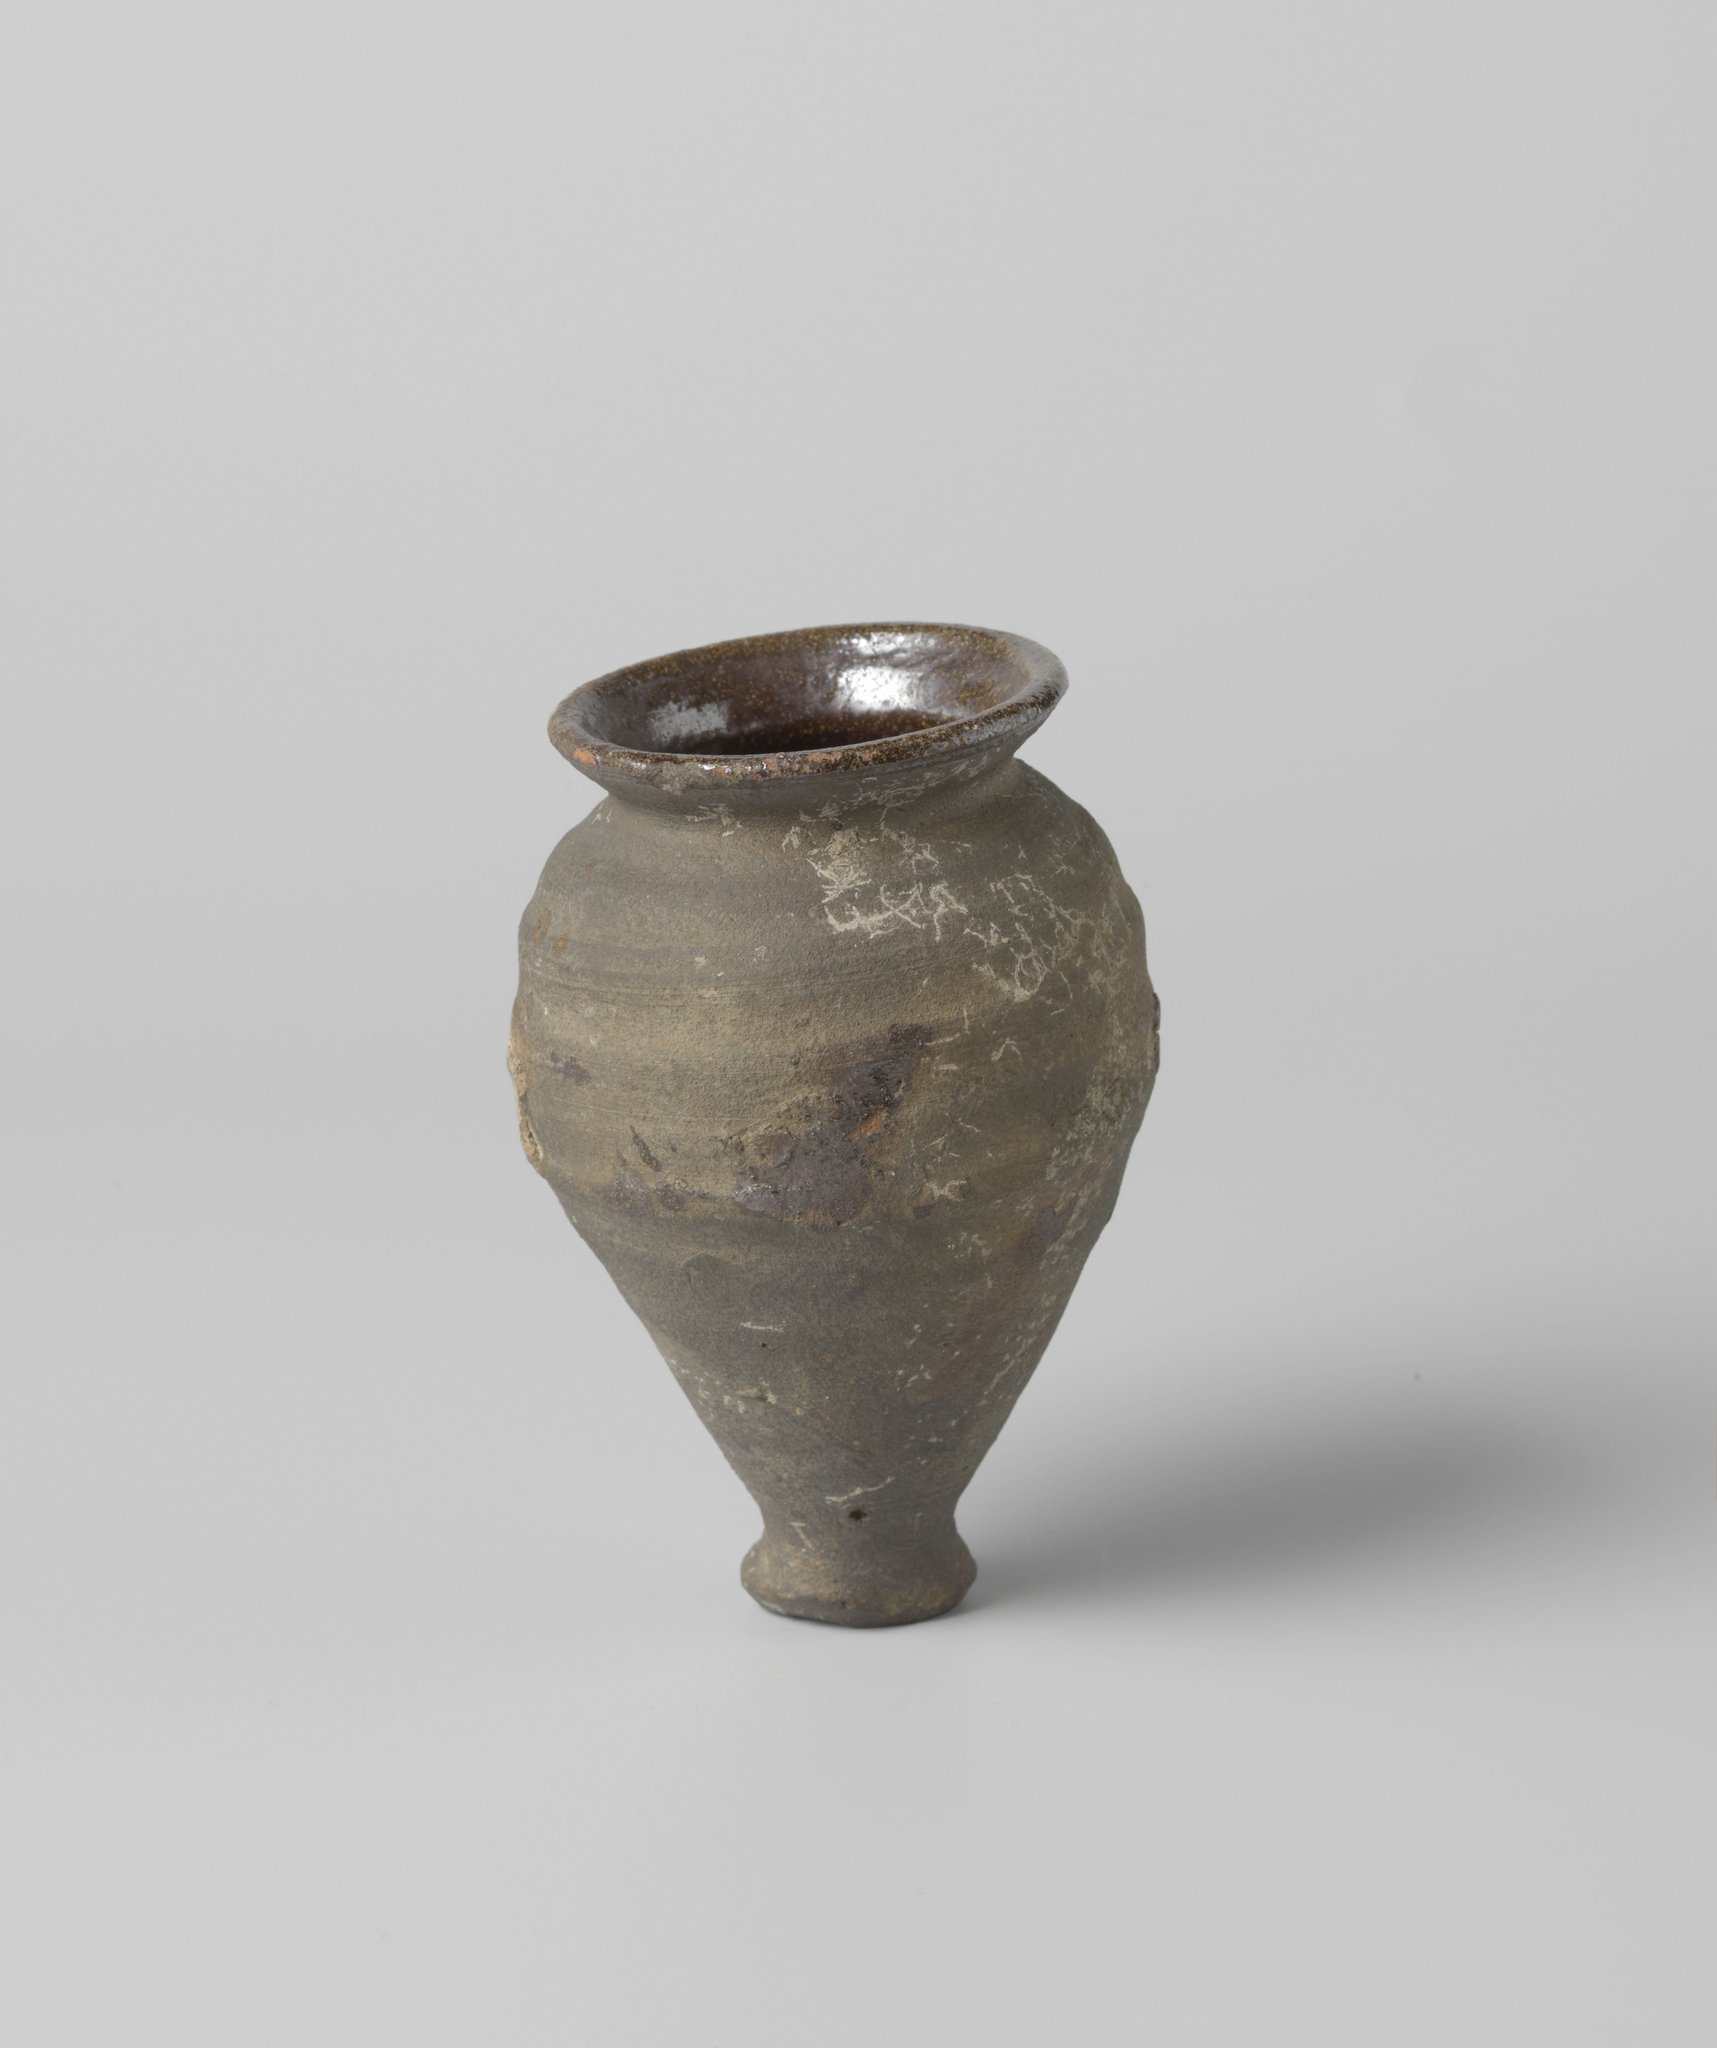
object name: jug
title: Kruik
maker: Anonymous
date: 1700-1800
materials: earthenware, glaze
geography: netherlands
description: Omgekeerd peervormige kruik (kroes) van loodglazuuraardewerk, op een kleine voet. De binnenzijde is groenachtig geglazuurd.